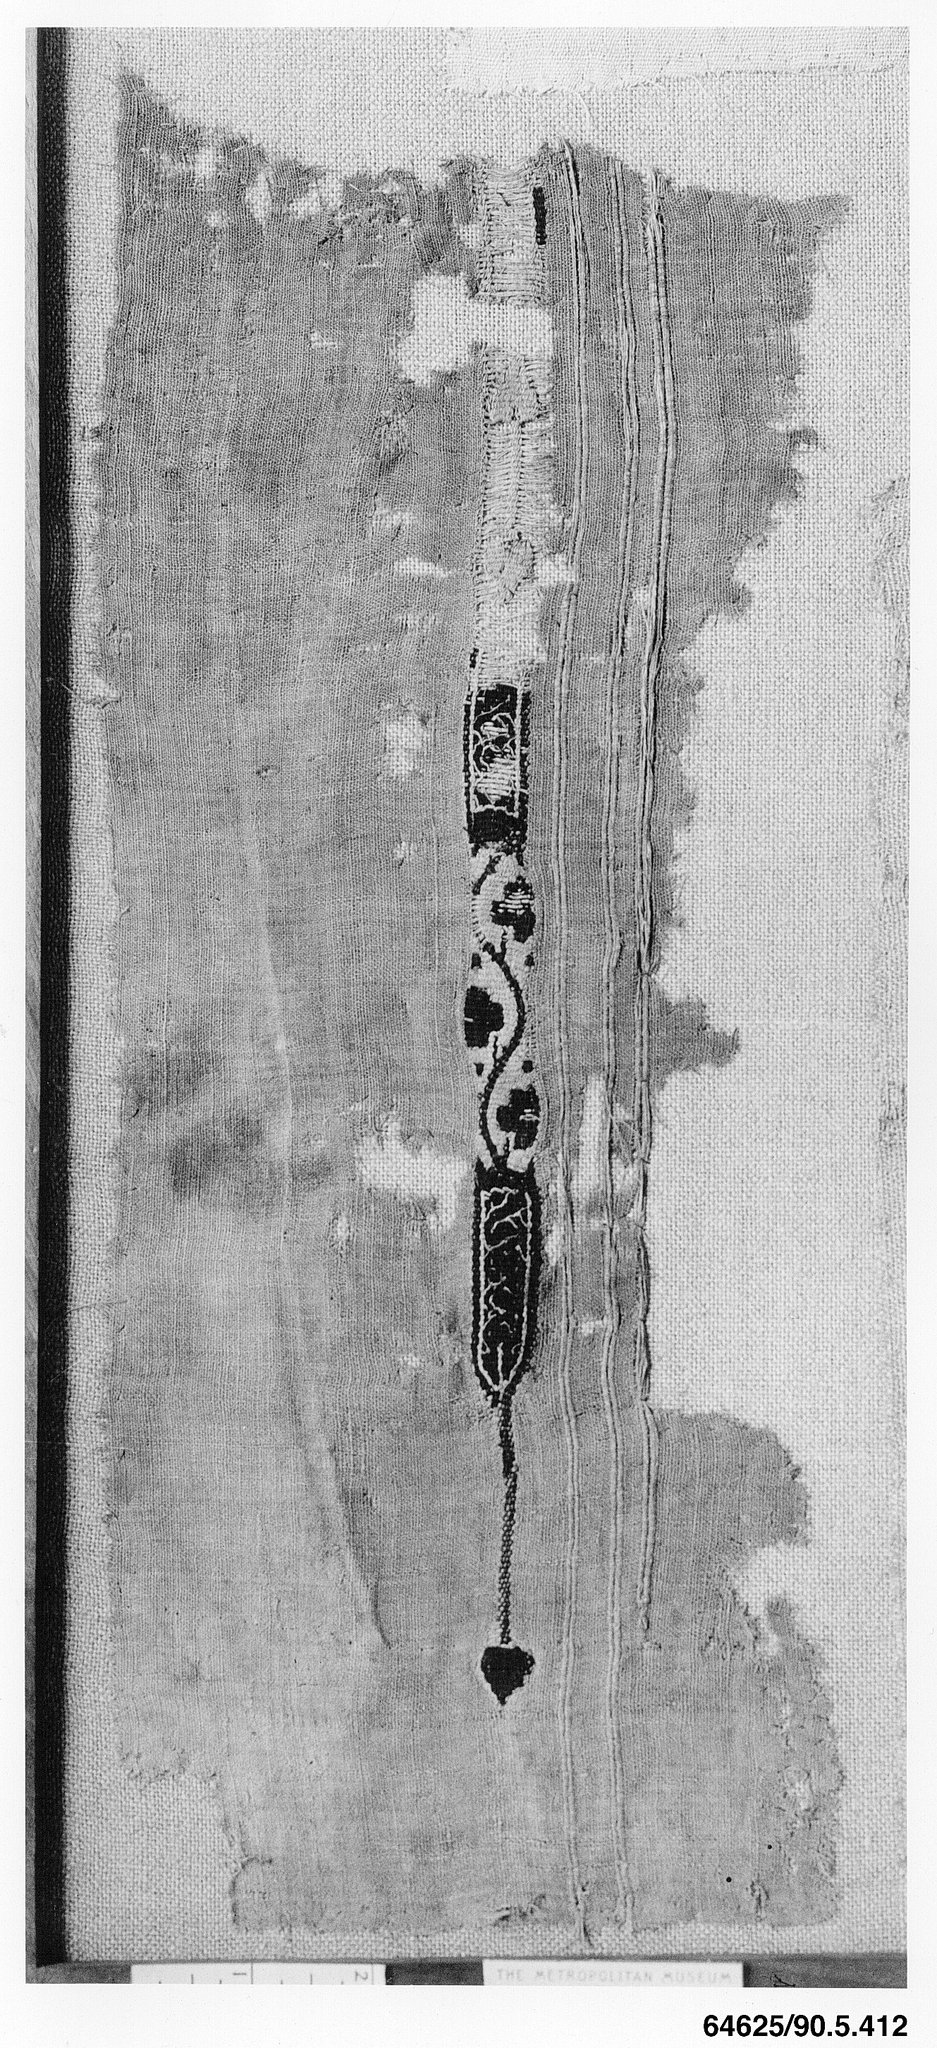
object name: textile fragment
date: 201-400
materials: linen, wool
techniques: weave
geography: egypt